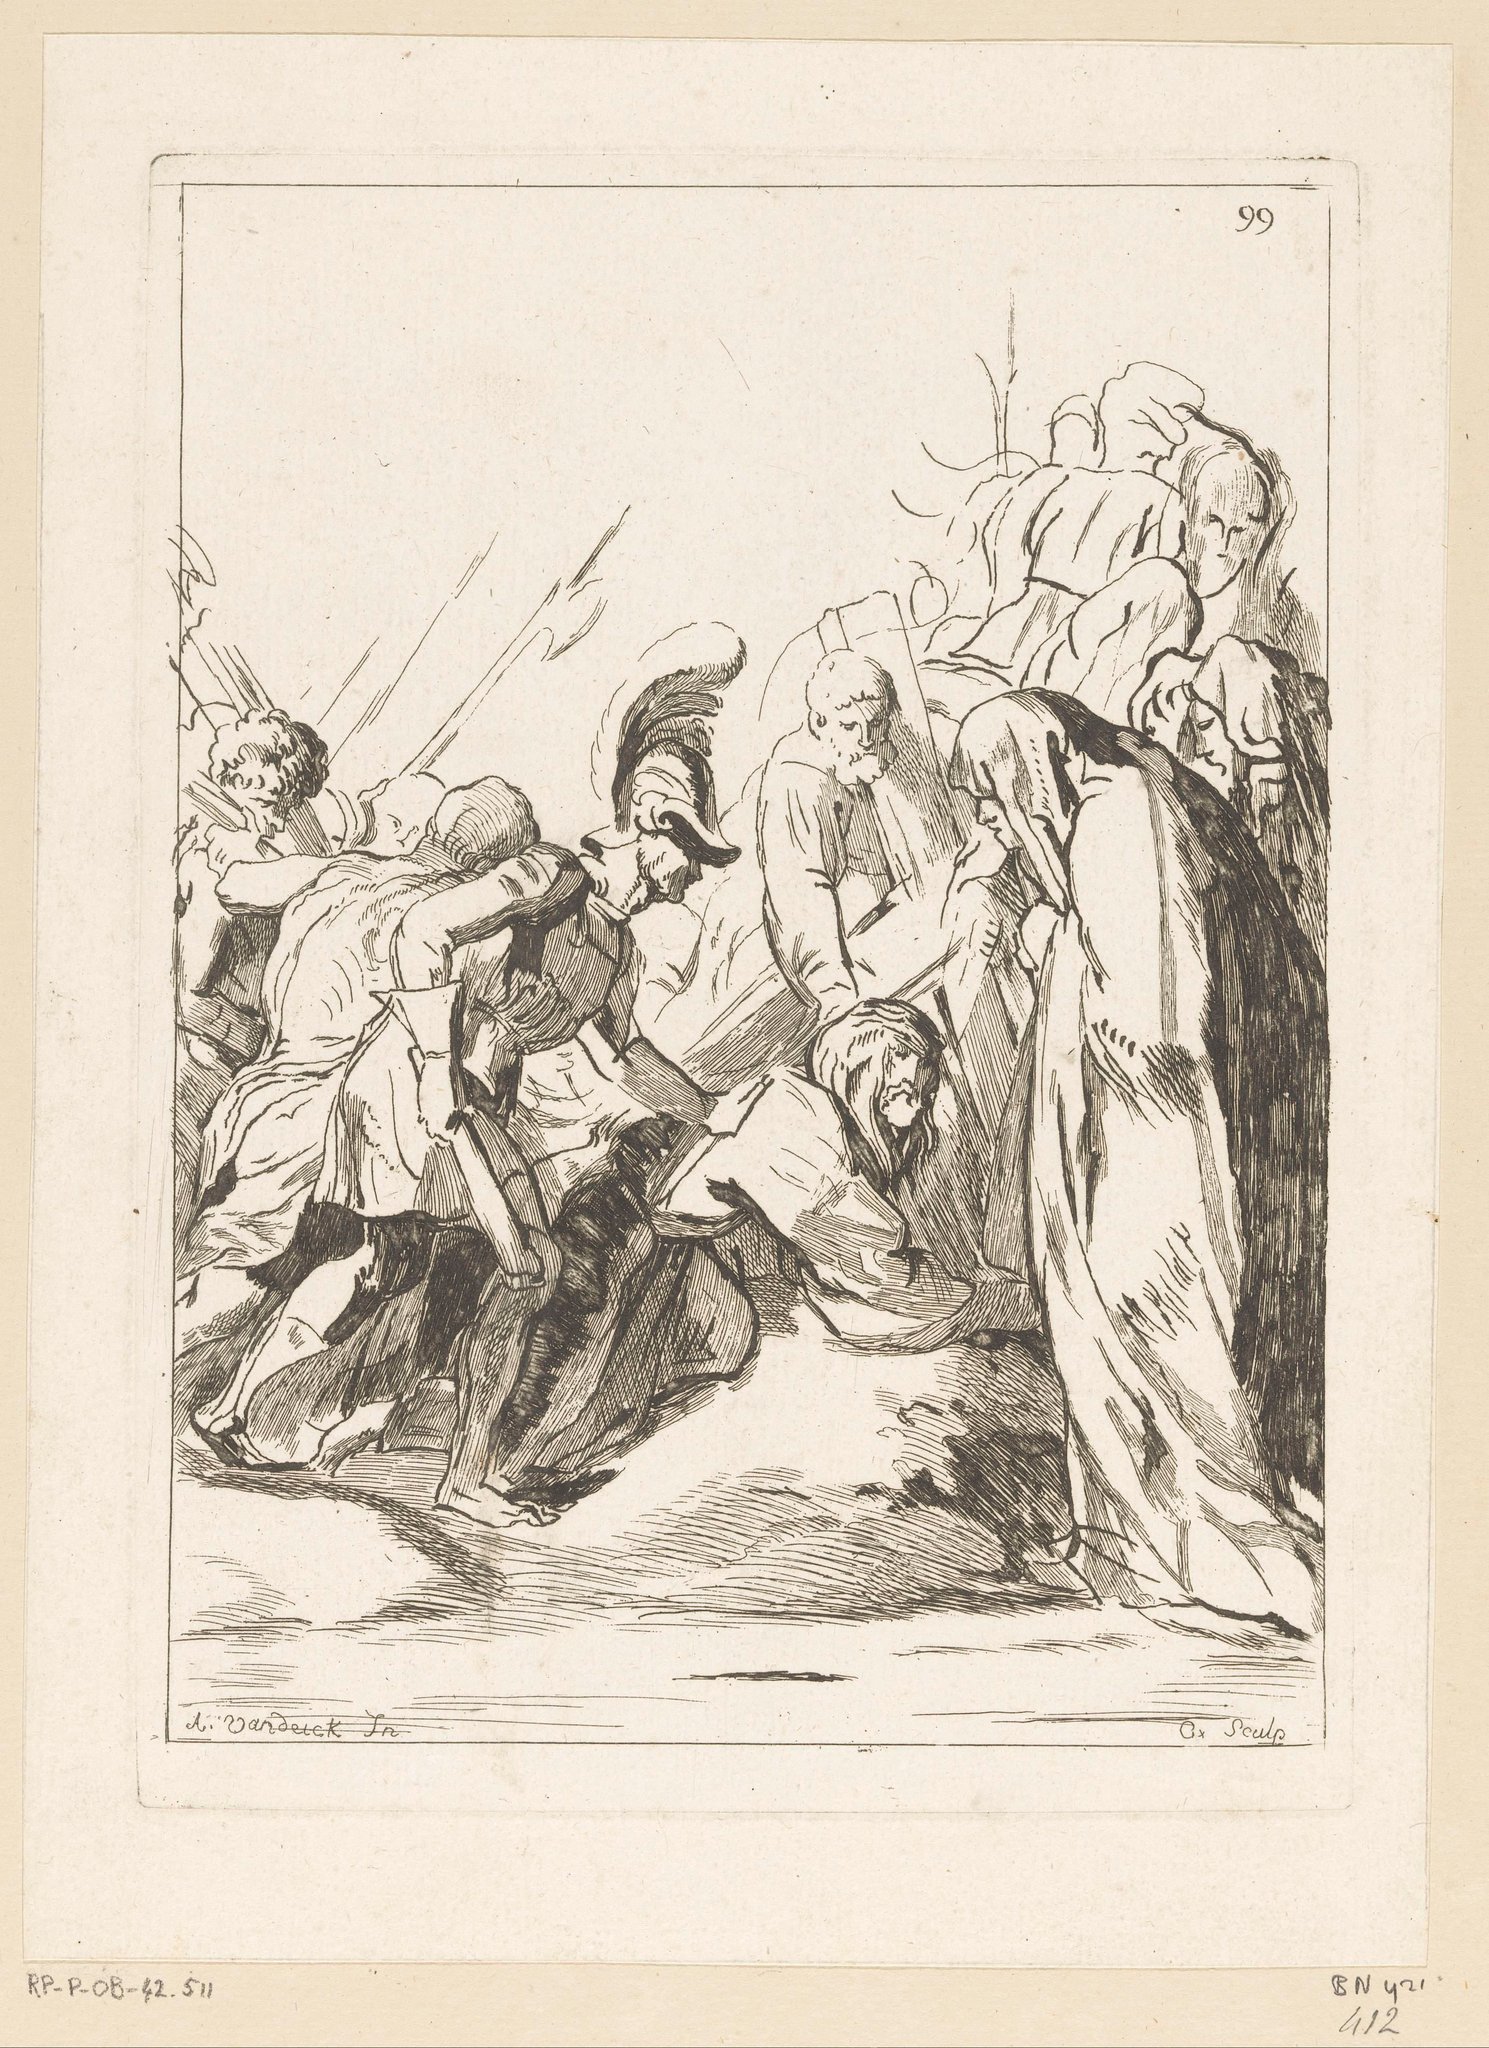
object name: print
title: Kruisdraging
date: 1702-1765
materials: paper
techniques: etching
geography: france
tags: christ meets veronica, who has a cloth to wipe christ's face, carrying of the cross: christ bearing the cross, alone or with the help of others (e.g. simon the cyrenian)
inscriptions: collector's mark: Lugt 240